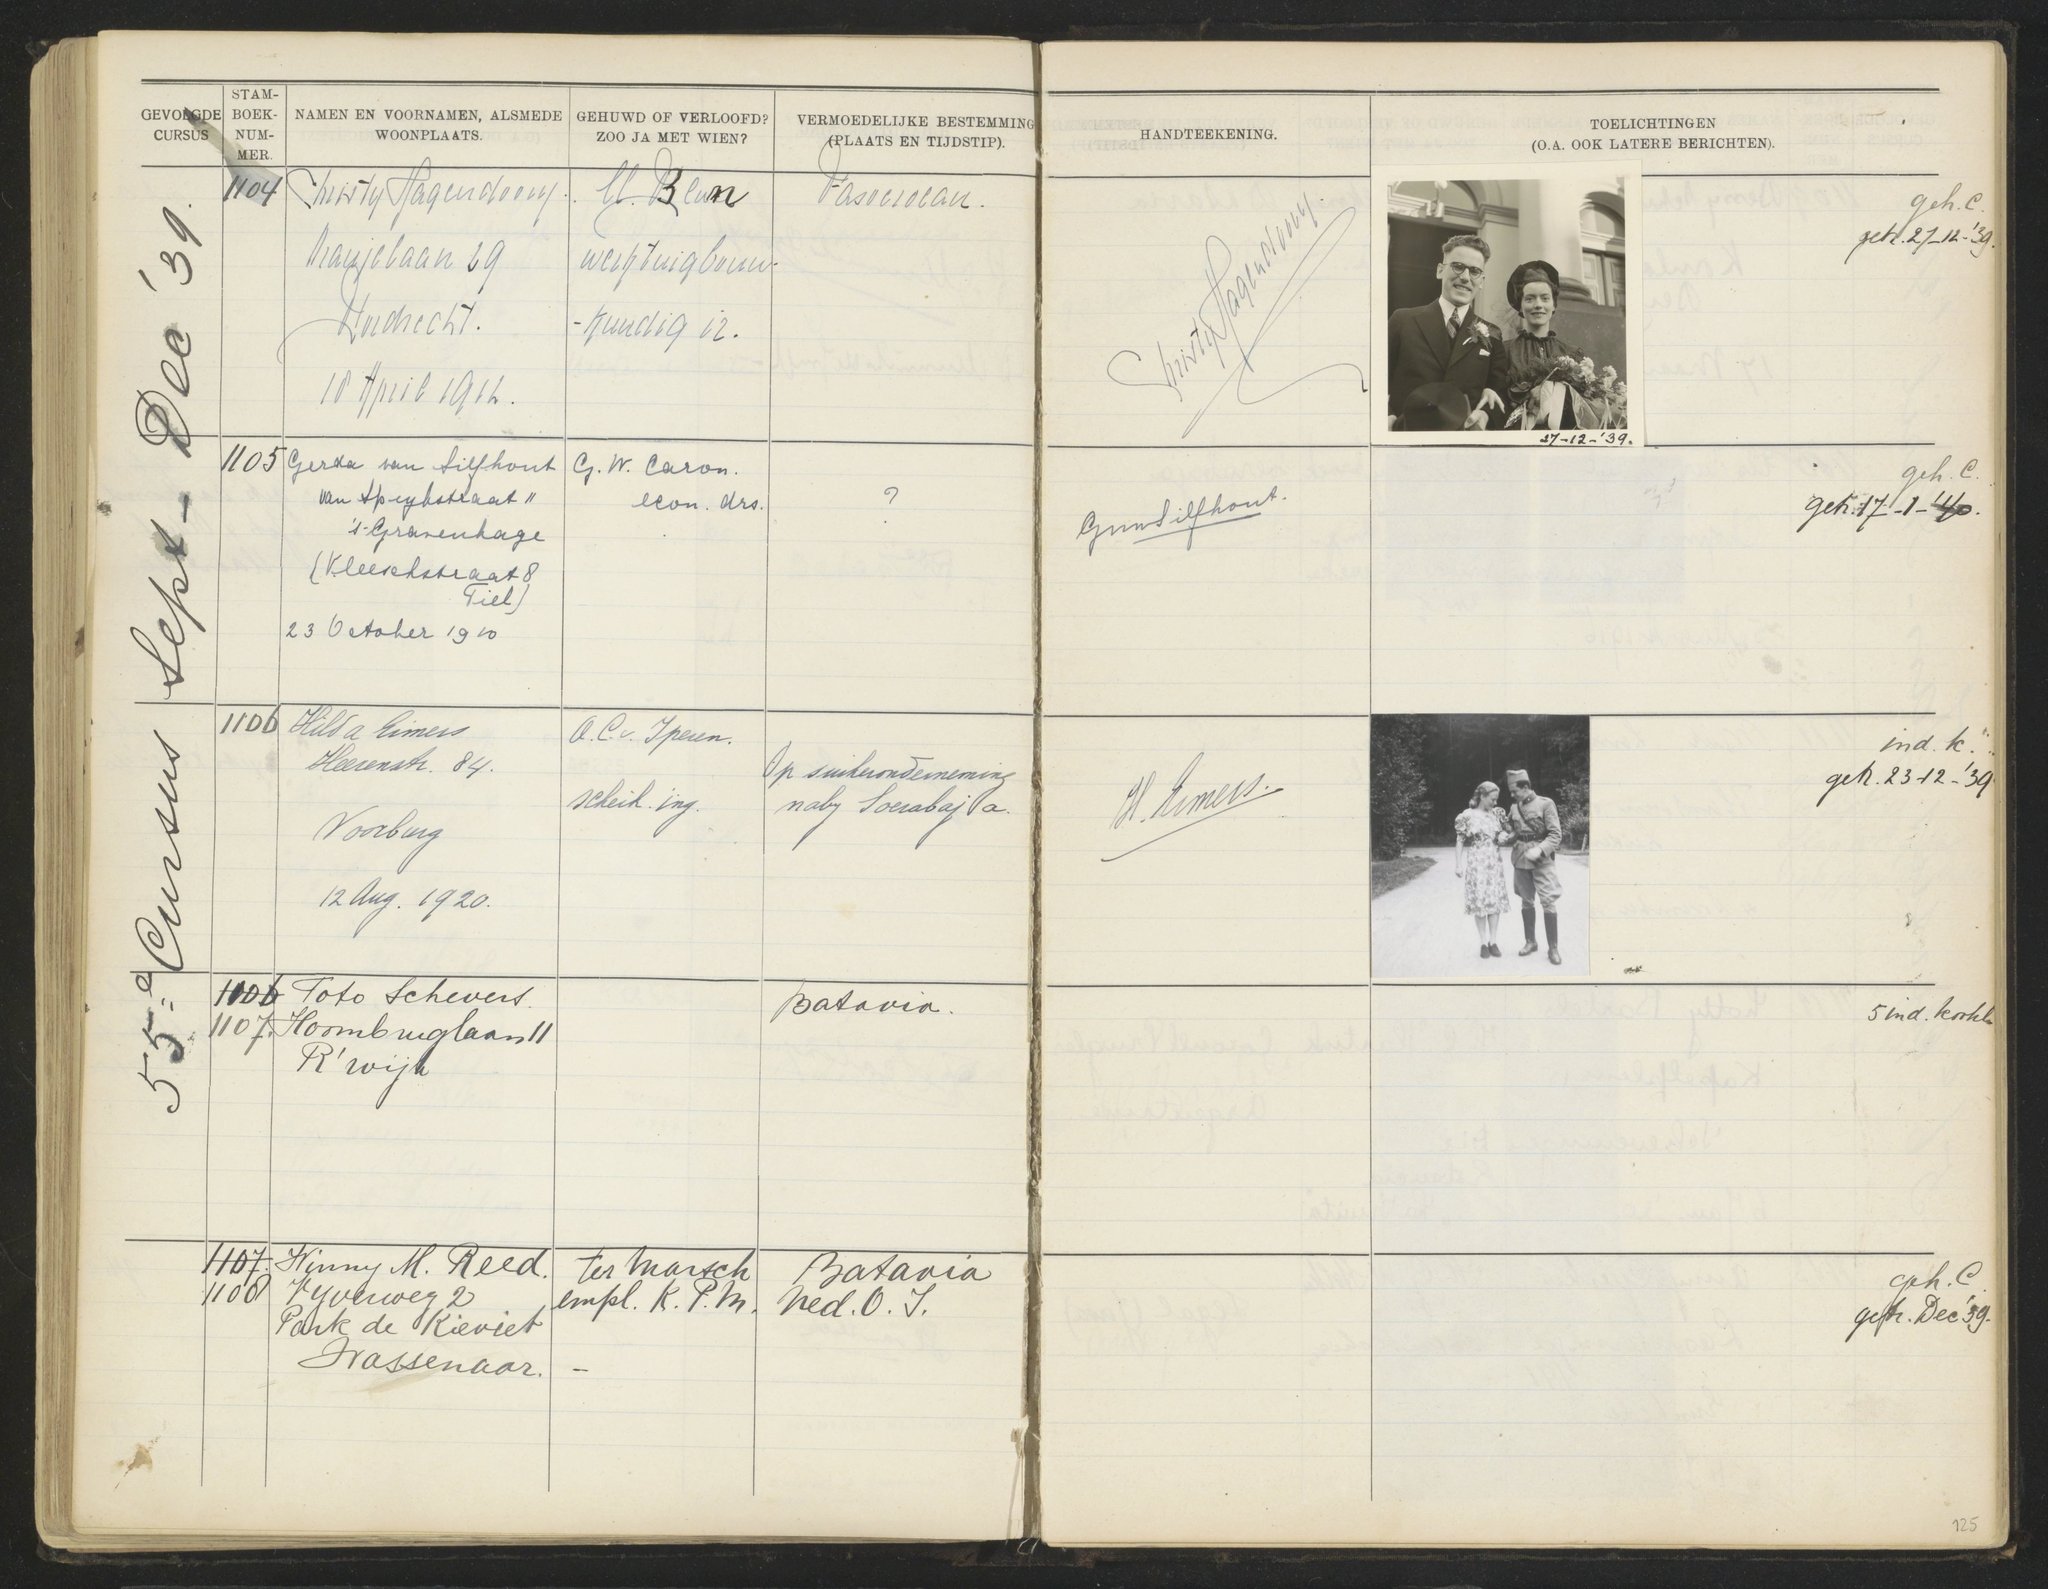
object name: album leaf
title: Blad 125 uit Stamboek van de leerlingen der Koloniale School voor Meisjes en Vrouwen te 's-Gravenhage deel II (1930-1949)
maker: Anonymous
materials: paper, photographic support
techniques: photography, printing, writing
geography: the hague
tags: further education (+ pupil), further education, the hague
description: Twee pagina's met gegevens van de deelnemers aan de 55e driemaandelijkse cursus van september tot december 1939, stamboeknummers 1104 tot en met 1108. Onderdeel van Stamboek van de leerlingen der Koloniale School voor Meisjes en Vrouwen te 's-Gravenhage deel II (1930-1949).